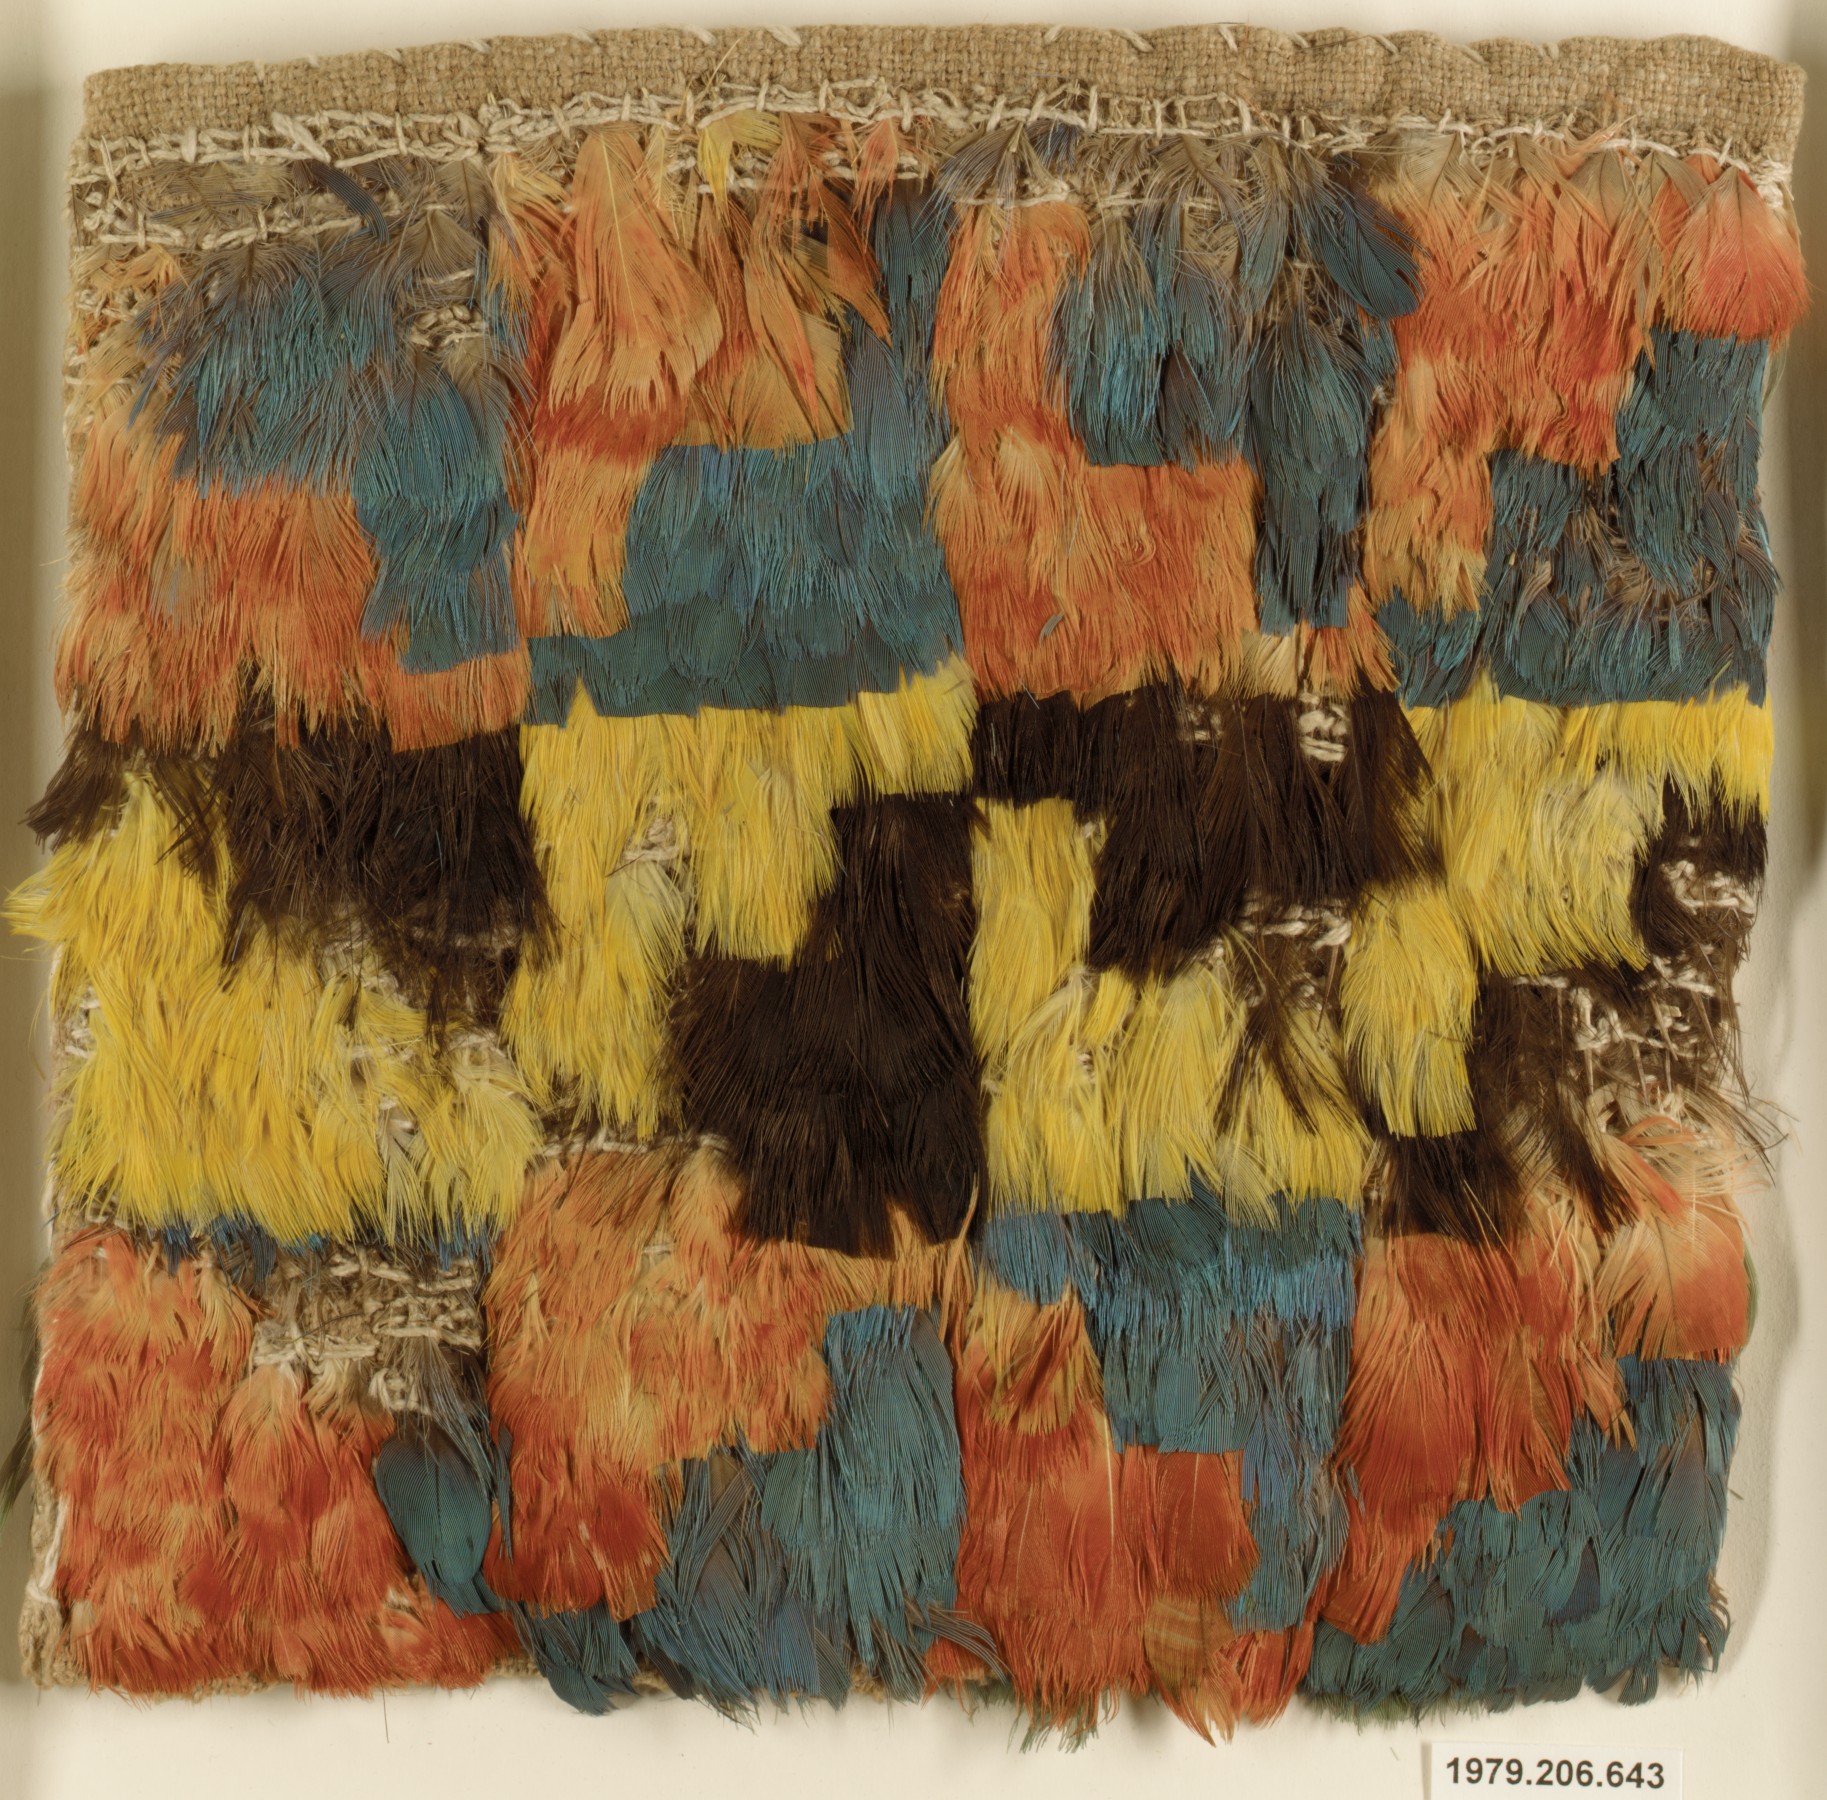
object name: miniature dress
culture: ica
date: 1101-1300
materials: cotton, feather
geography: peru